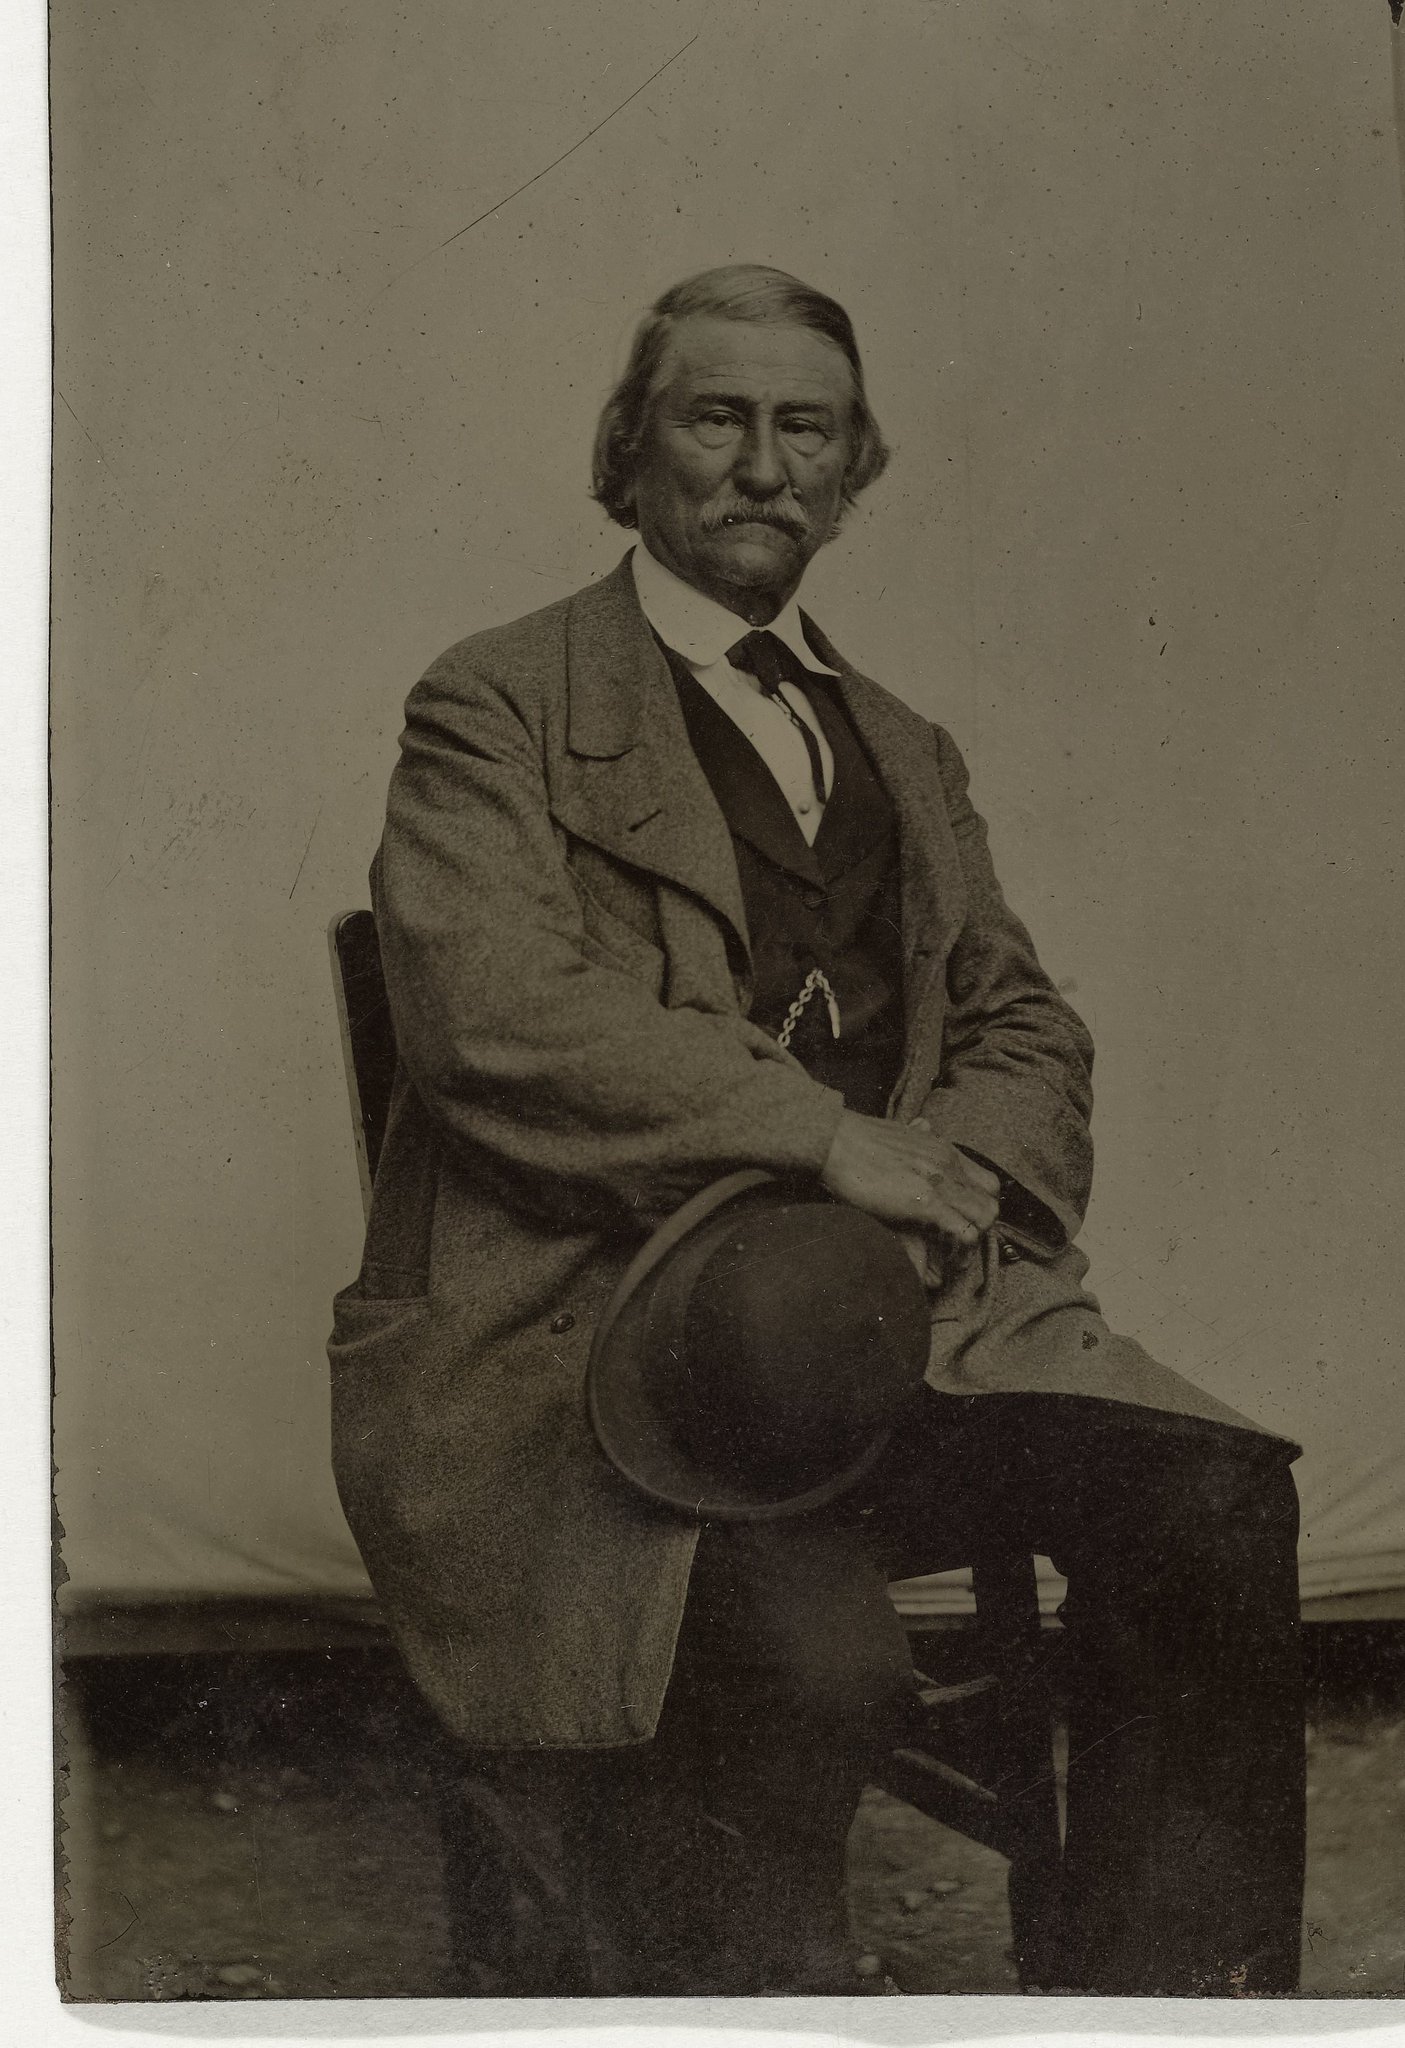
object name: photograph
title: Portret van August Kappler, stichter van de stad Albina in Suriname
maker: Anonymous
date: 1875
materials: metal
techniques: ferrotyping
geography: stuttgart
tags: suriname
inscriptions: annotation: ‘August Kappler 1815 1887 Stuttgart Stichter Albina Suriname’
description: Portret van August Kappler, stichter van de stad Albina in Suriname. Onderdeel van een groep objecten afkomstig van de familie Wesenhagen in Suriname.